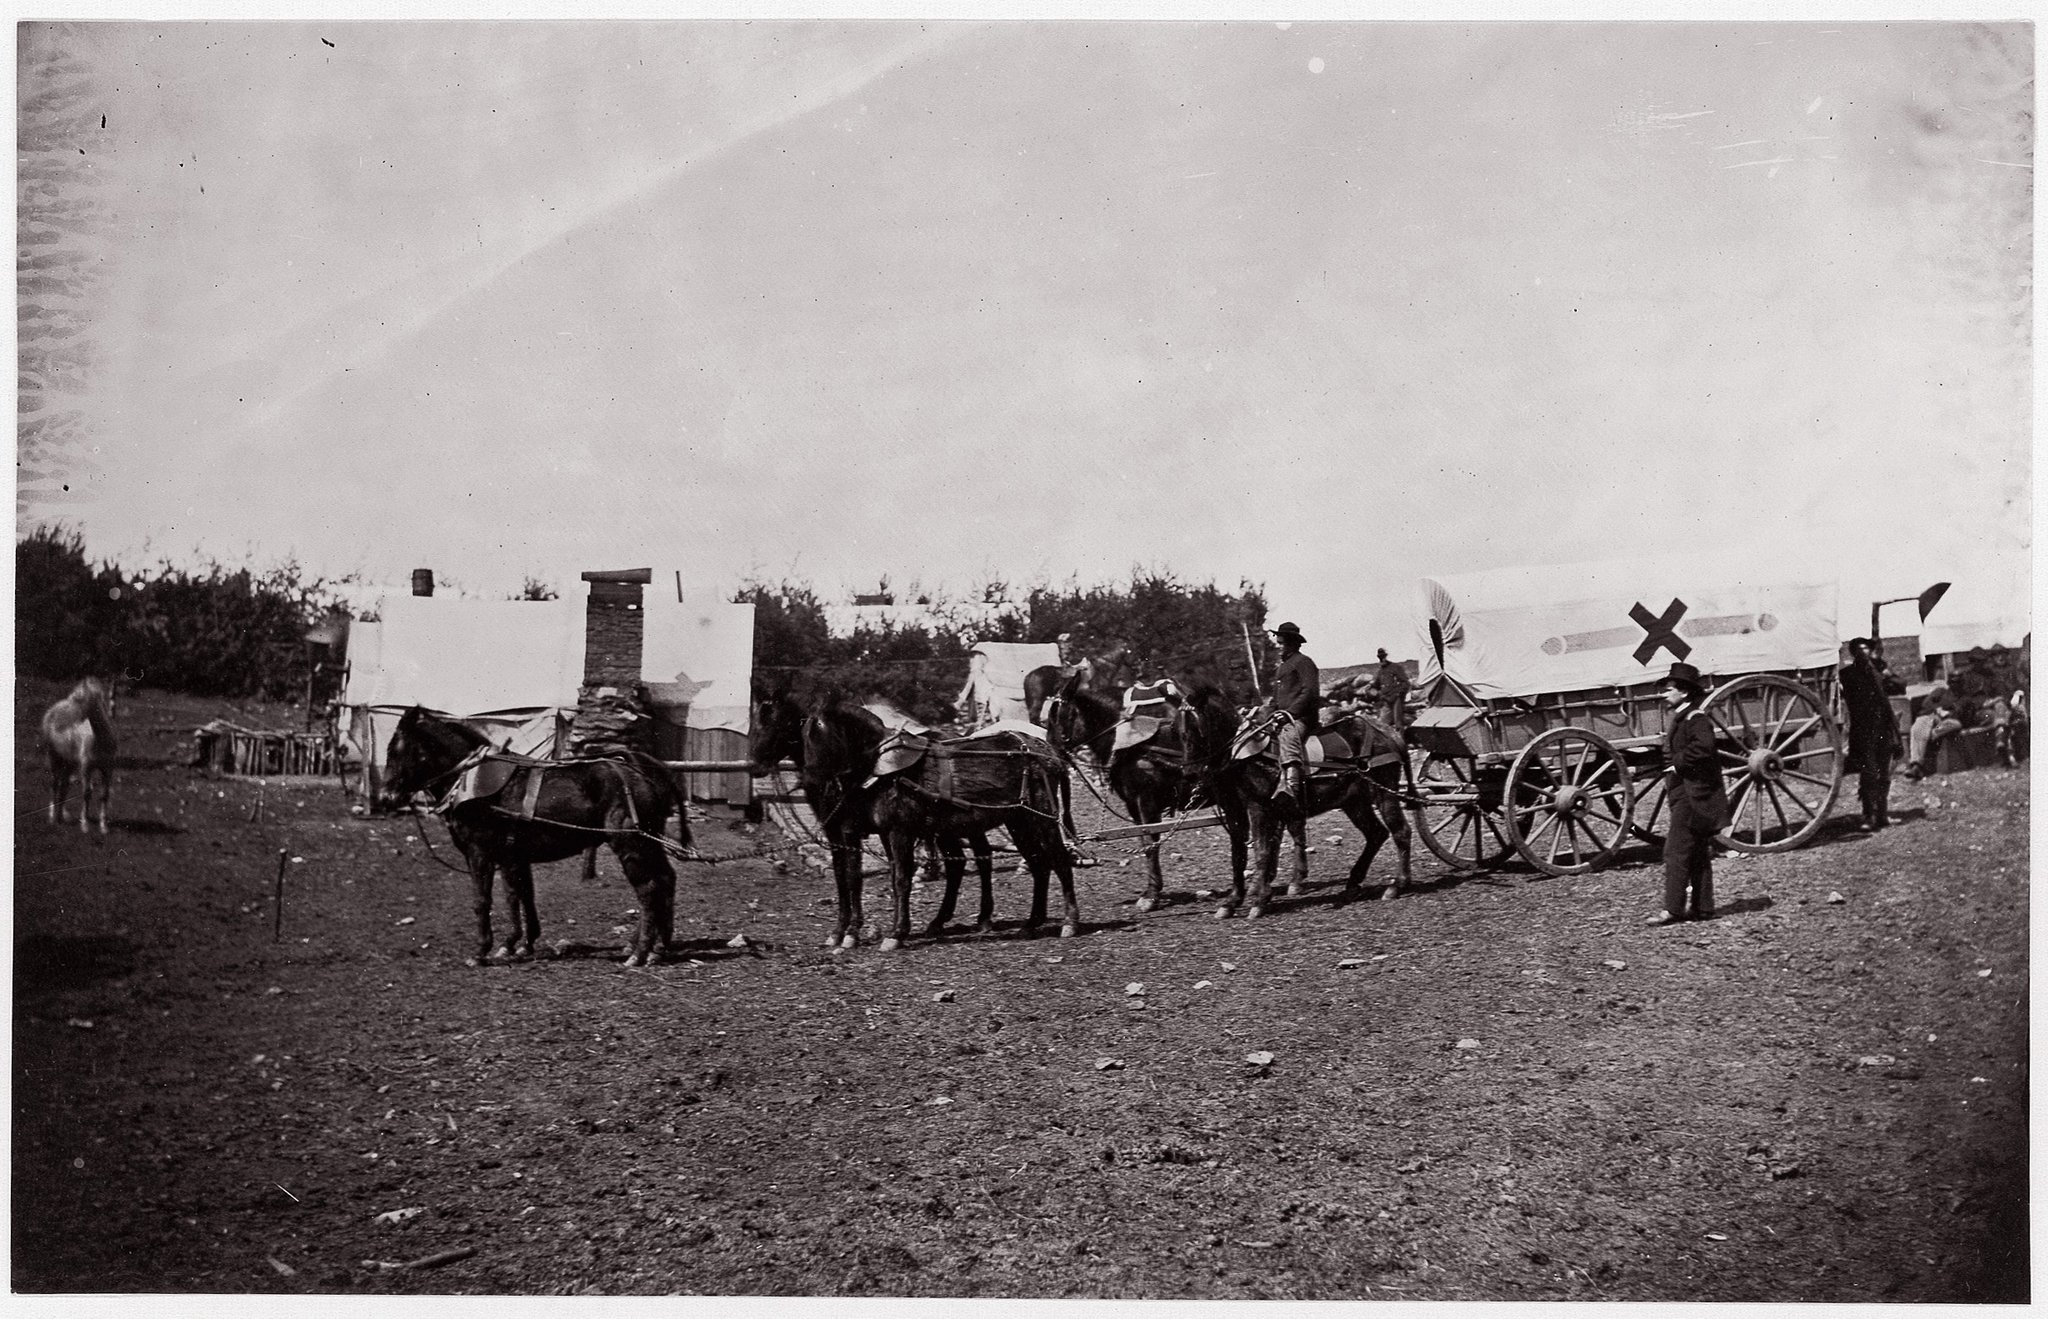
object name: photograph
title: The Crack Team of the 1st Division, 6th Corps near Hazel River, Virginia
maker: timothy h. o'sullivan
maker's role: artist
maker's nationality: american, born ireland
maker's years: 1840-1882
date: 1861-1865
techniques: albumen silver print, glass negative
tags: american civil war,men,horses,wagons